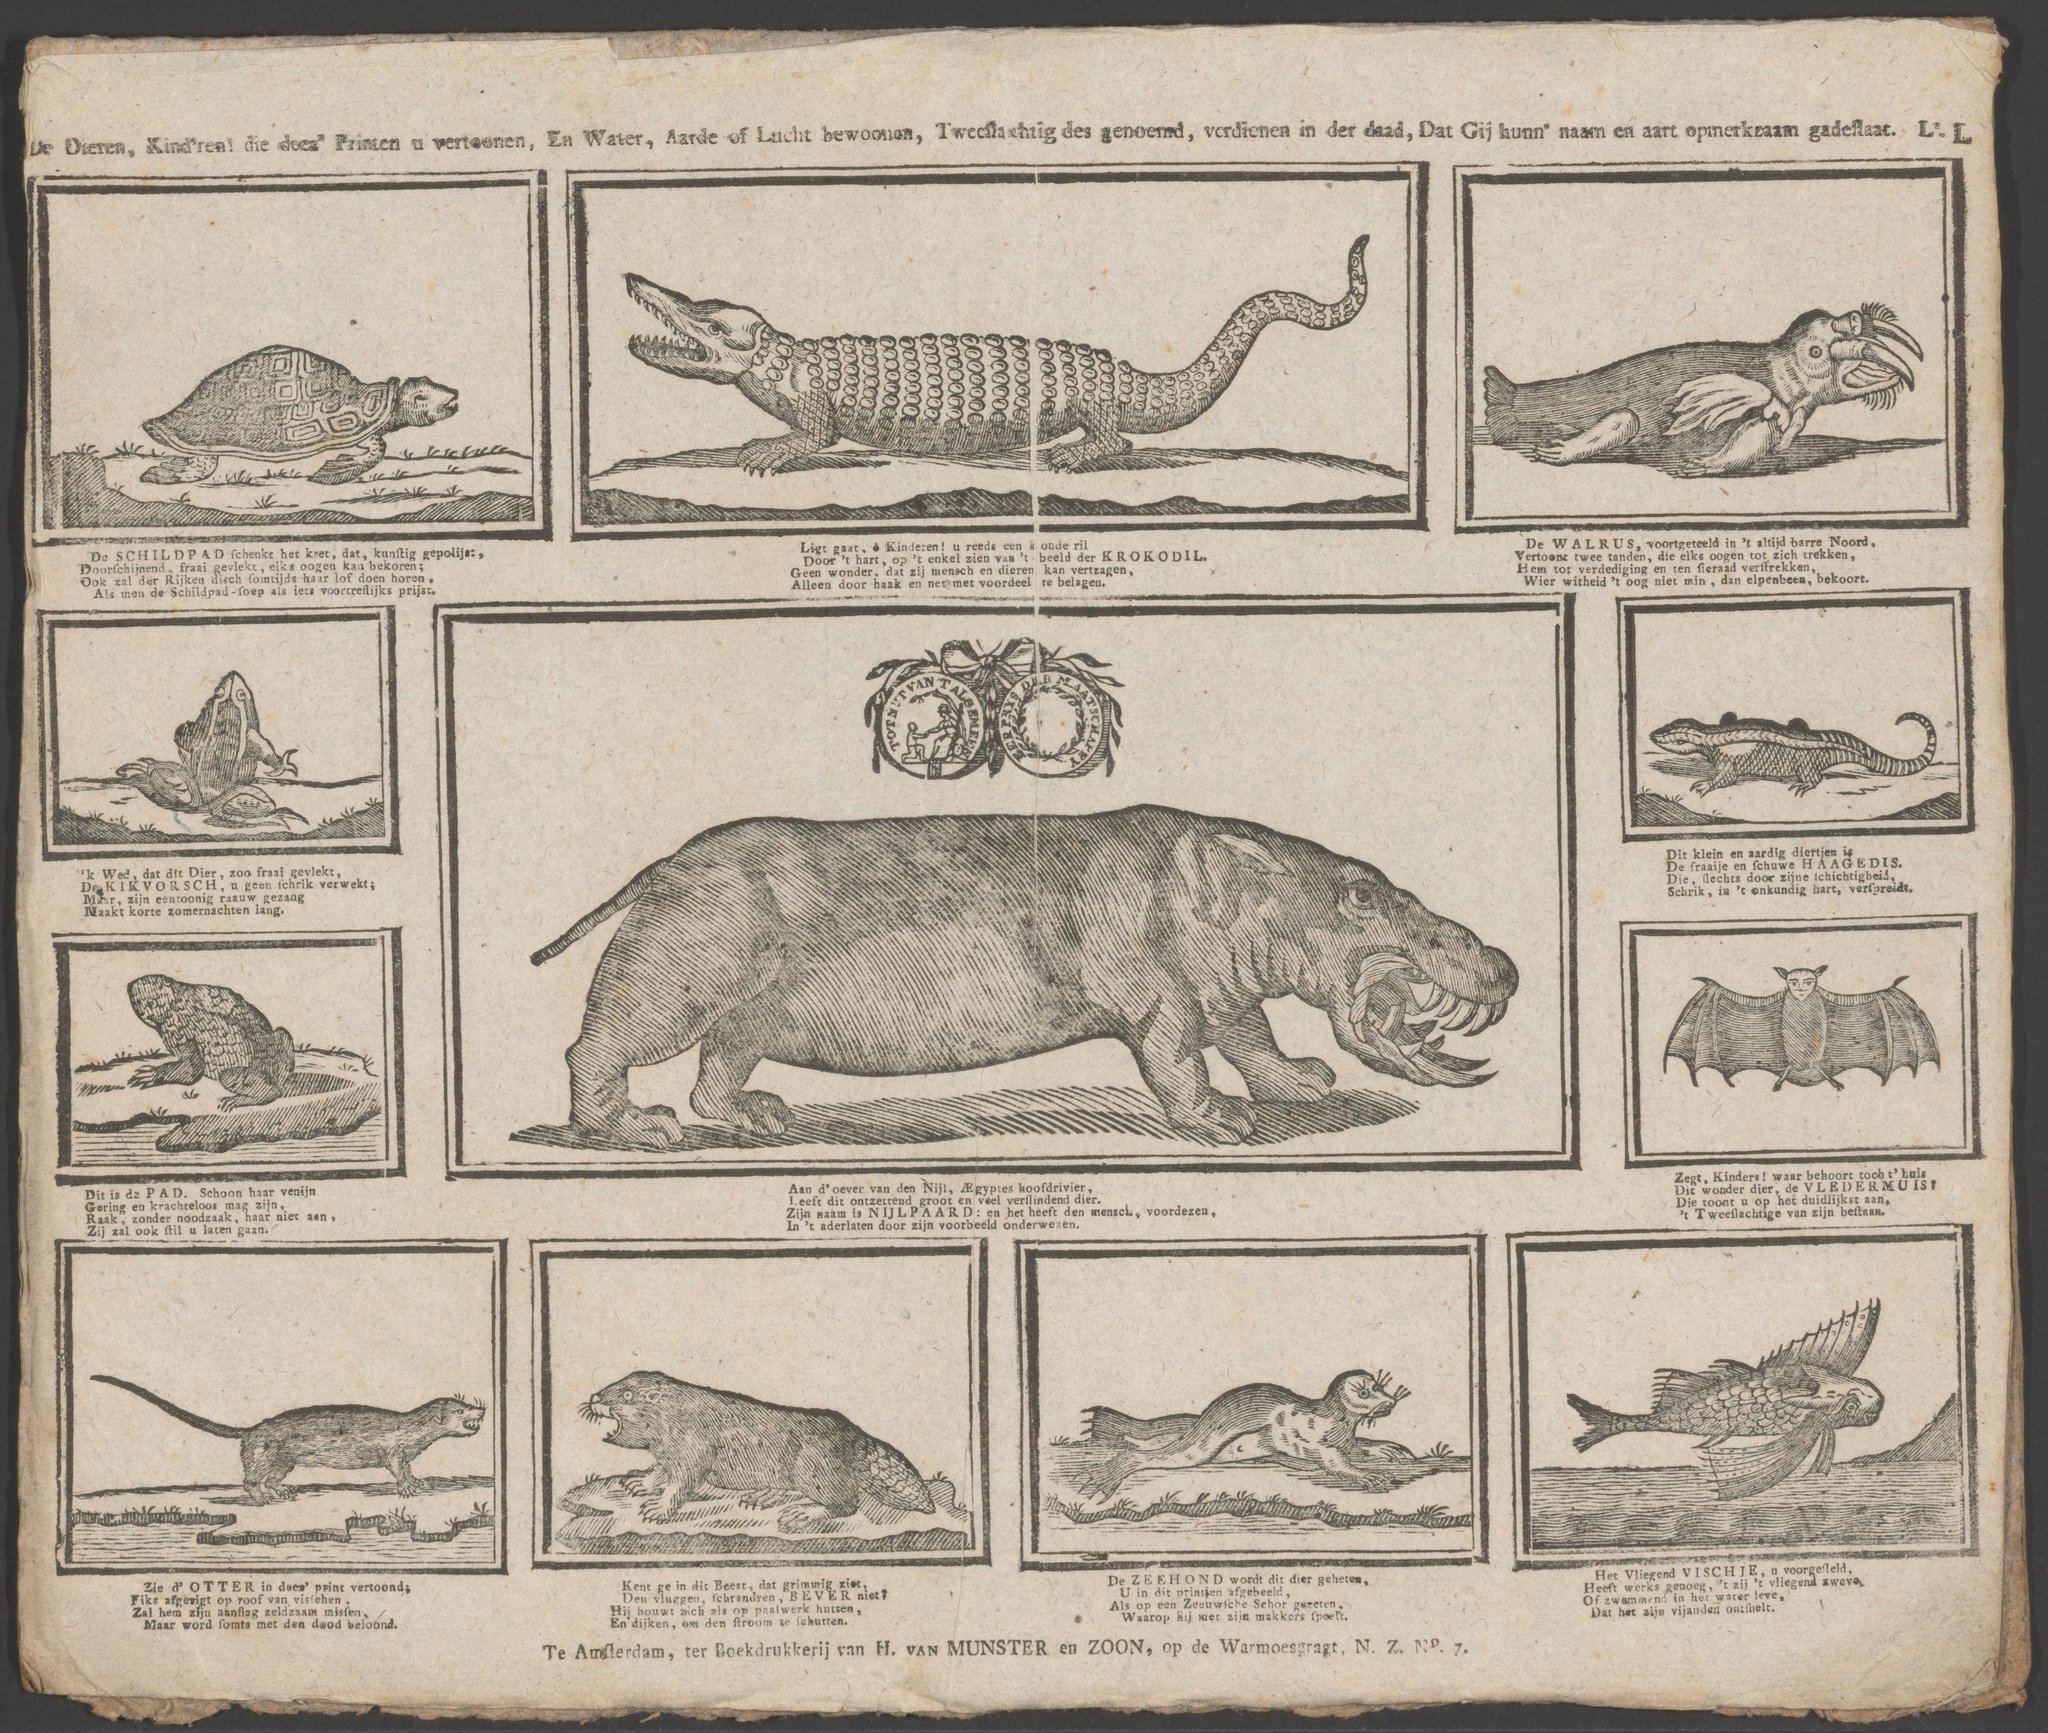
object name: print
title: Nijlpaard, krokodil en andere dieren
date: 1784-1849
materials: paper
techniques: letterpress printing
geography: amsterdam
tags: flying mammals: bat, reptiles, fishes, swimming mammals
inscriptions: stamp, collector's mark: Lugt 1641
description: Blad met twaalf voorstellingen van amfibieën, reptielen, zoogdieren en een vis. In het midden het zegel van de Maatschappij tot Nut van 't Algemeen. Onder elke afbeelding een vierregelig vers met de naam van het dier. Genummerd rechtsboven: L.L. Onderwerpsrubrieken binnen de Atlas Zeden en Gewoonten: Zeden en gewoonten in engeren zin, Des menschen begin, midden en einde, Kinderprenten opgeplakt op karton.